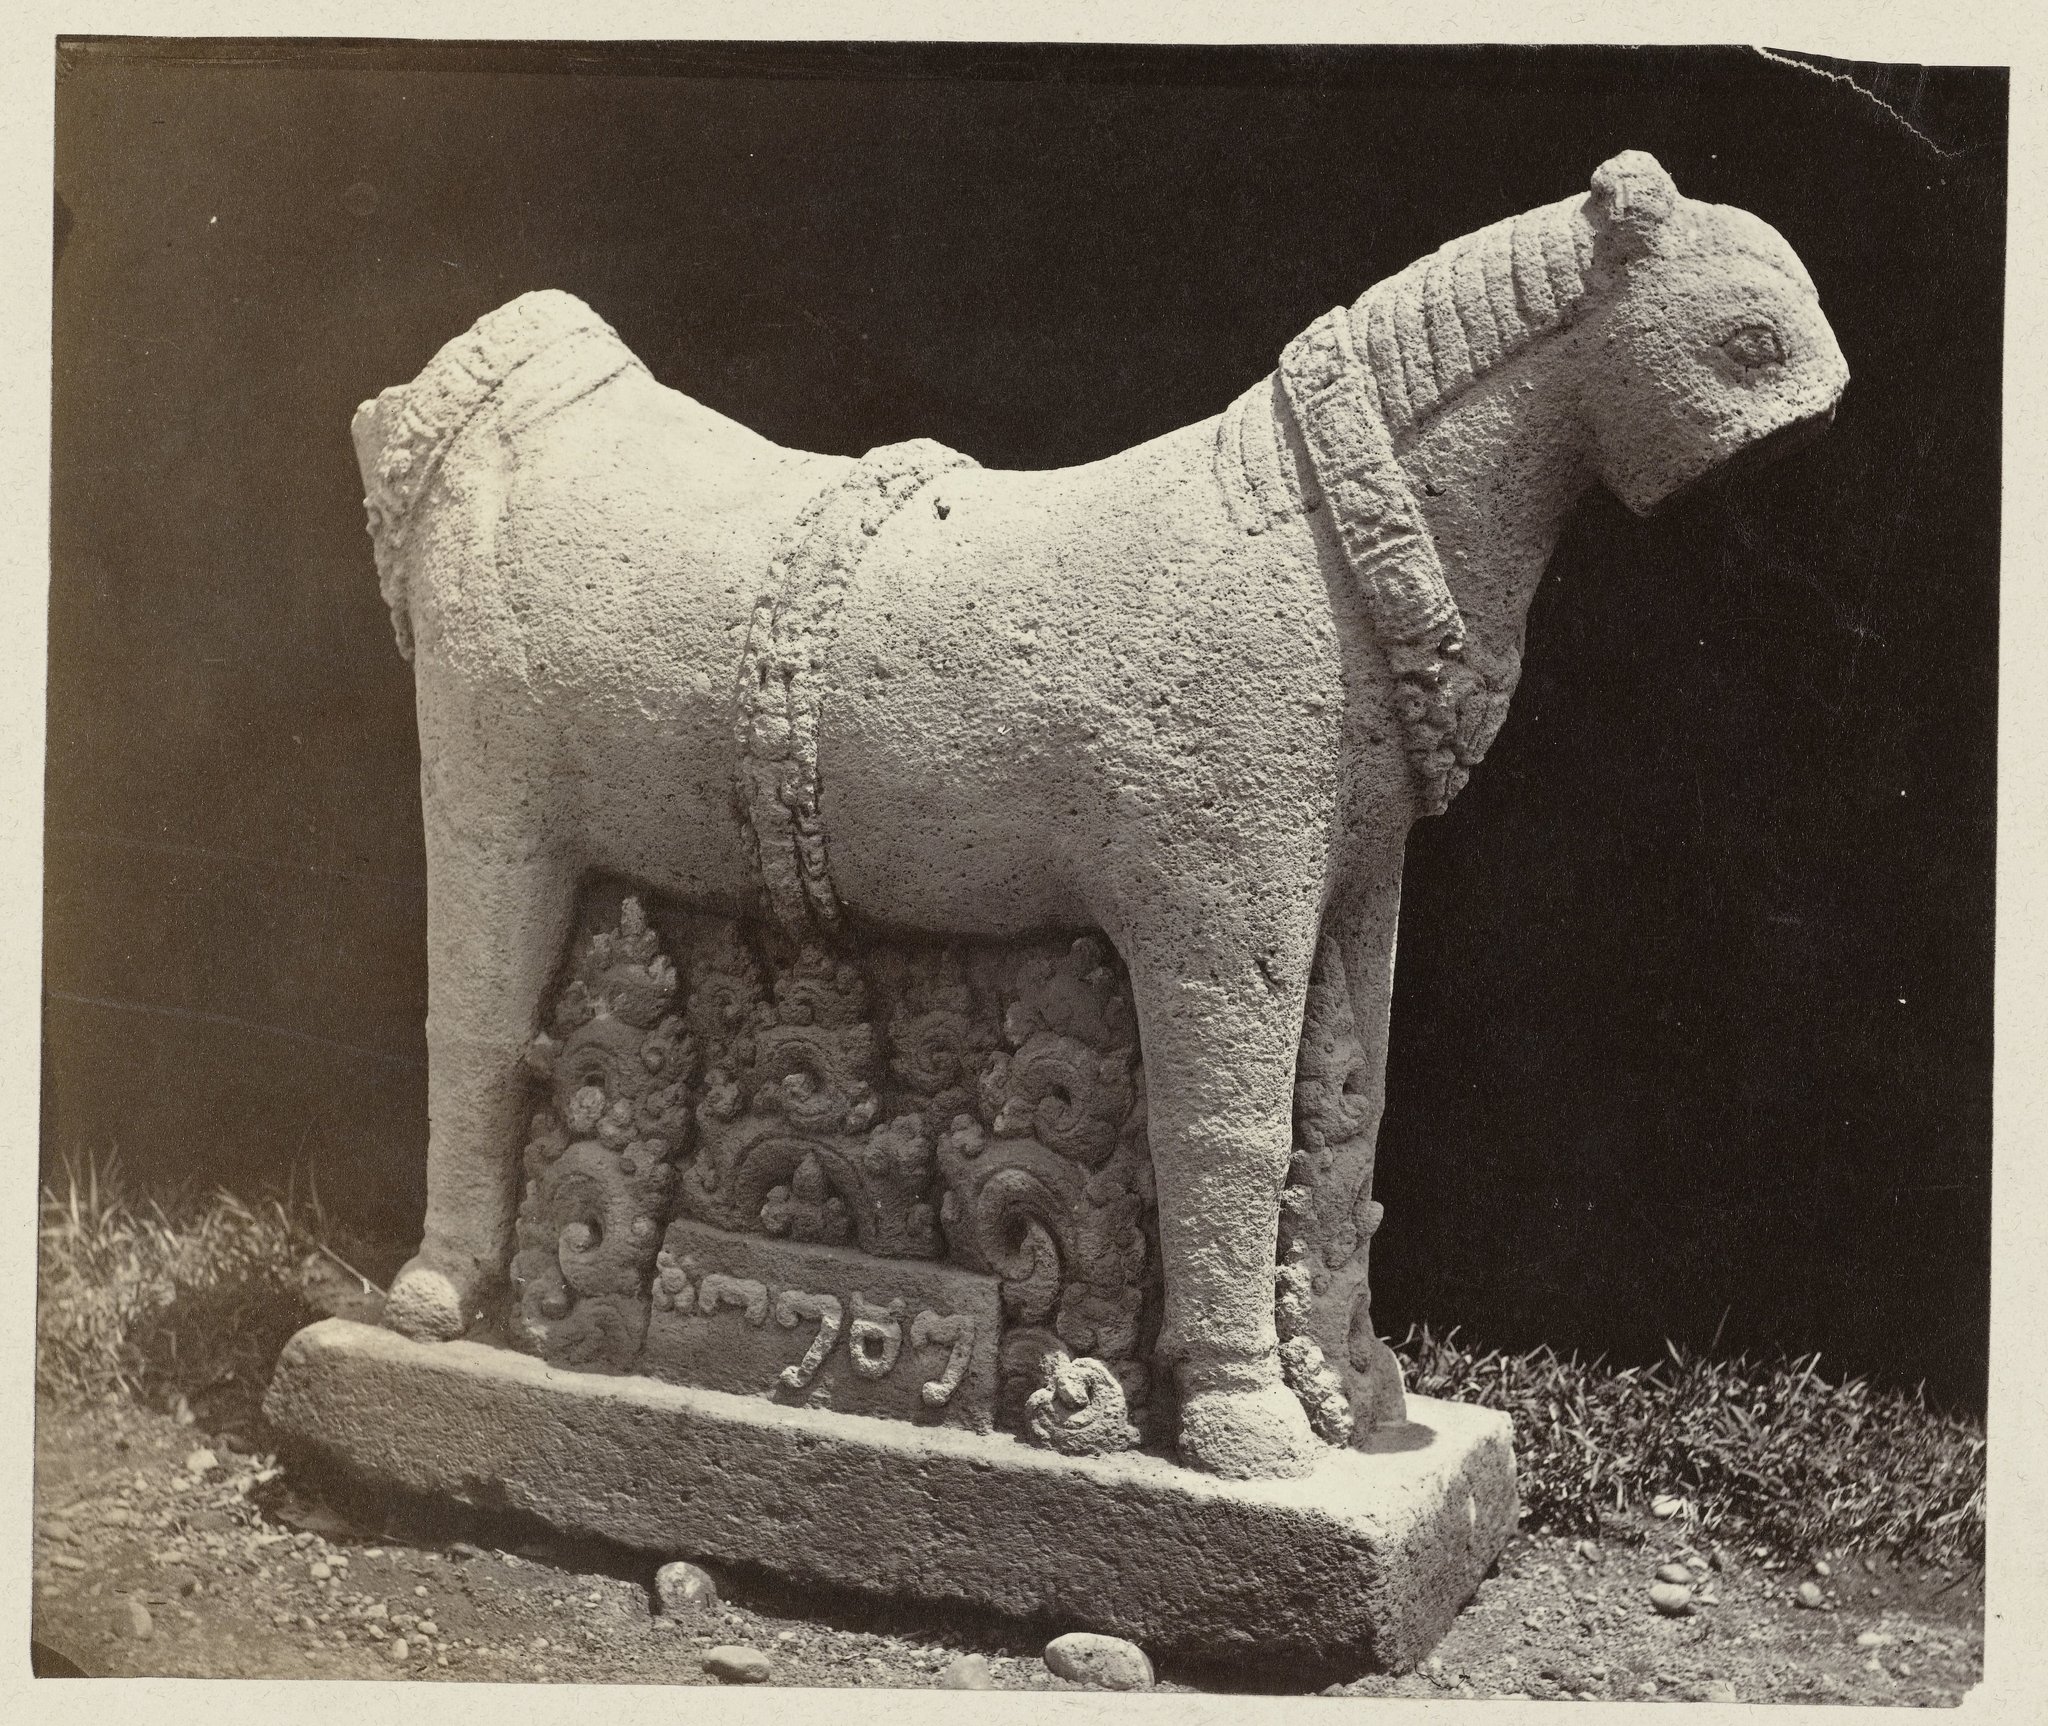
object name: photograph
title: Dated horse-like hybrid, said to come from Bogem. Kediri, Kediri district, East Java province, 1360-1361 AD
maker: isidore kinsbergen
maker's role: fotograaf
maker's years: 1821-1905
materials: cardboard, paper, photographic support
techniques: albumen print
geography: java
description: Het beeld was geplaats bij het residentie huis in Kediri.